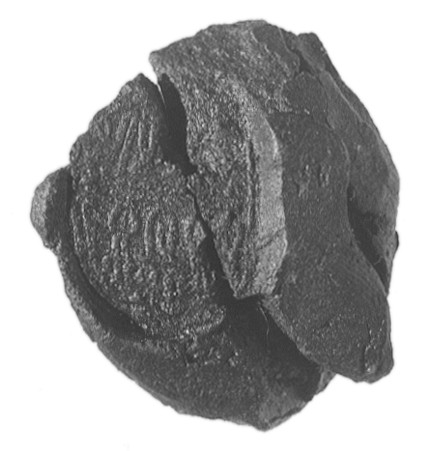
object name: sealing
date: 2030-1640 BCE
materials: clay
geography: egypt